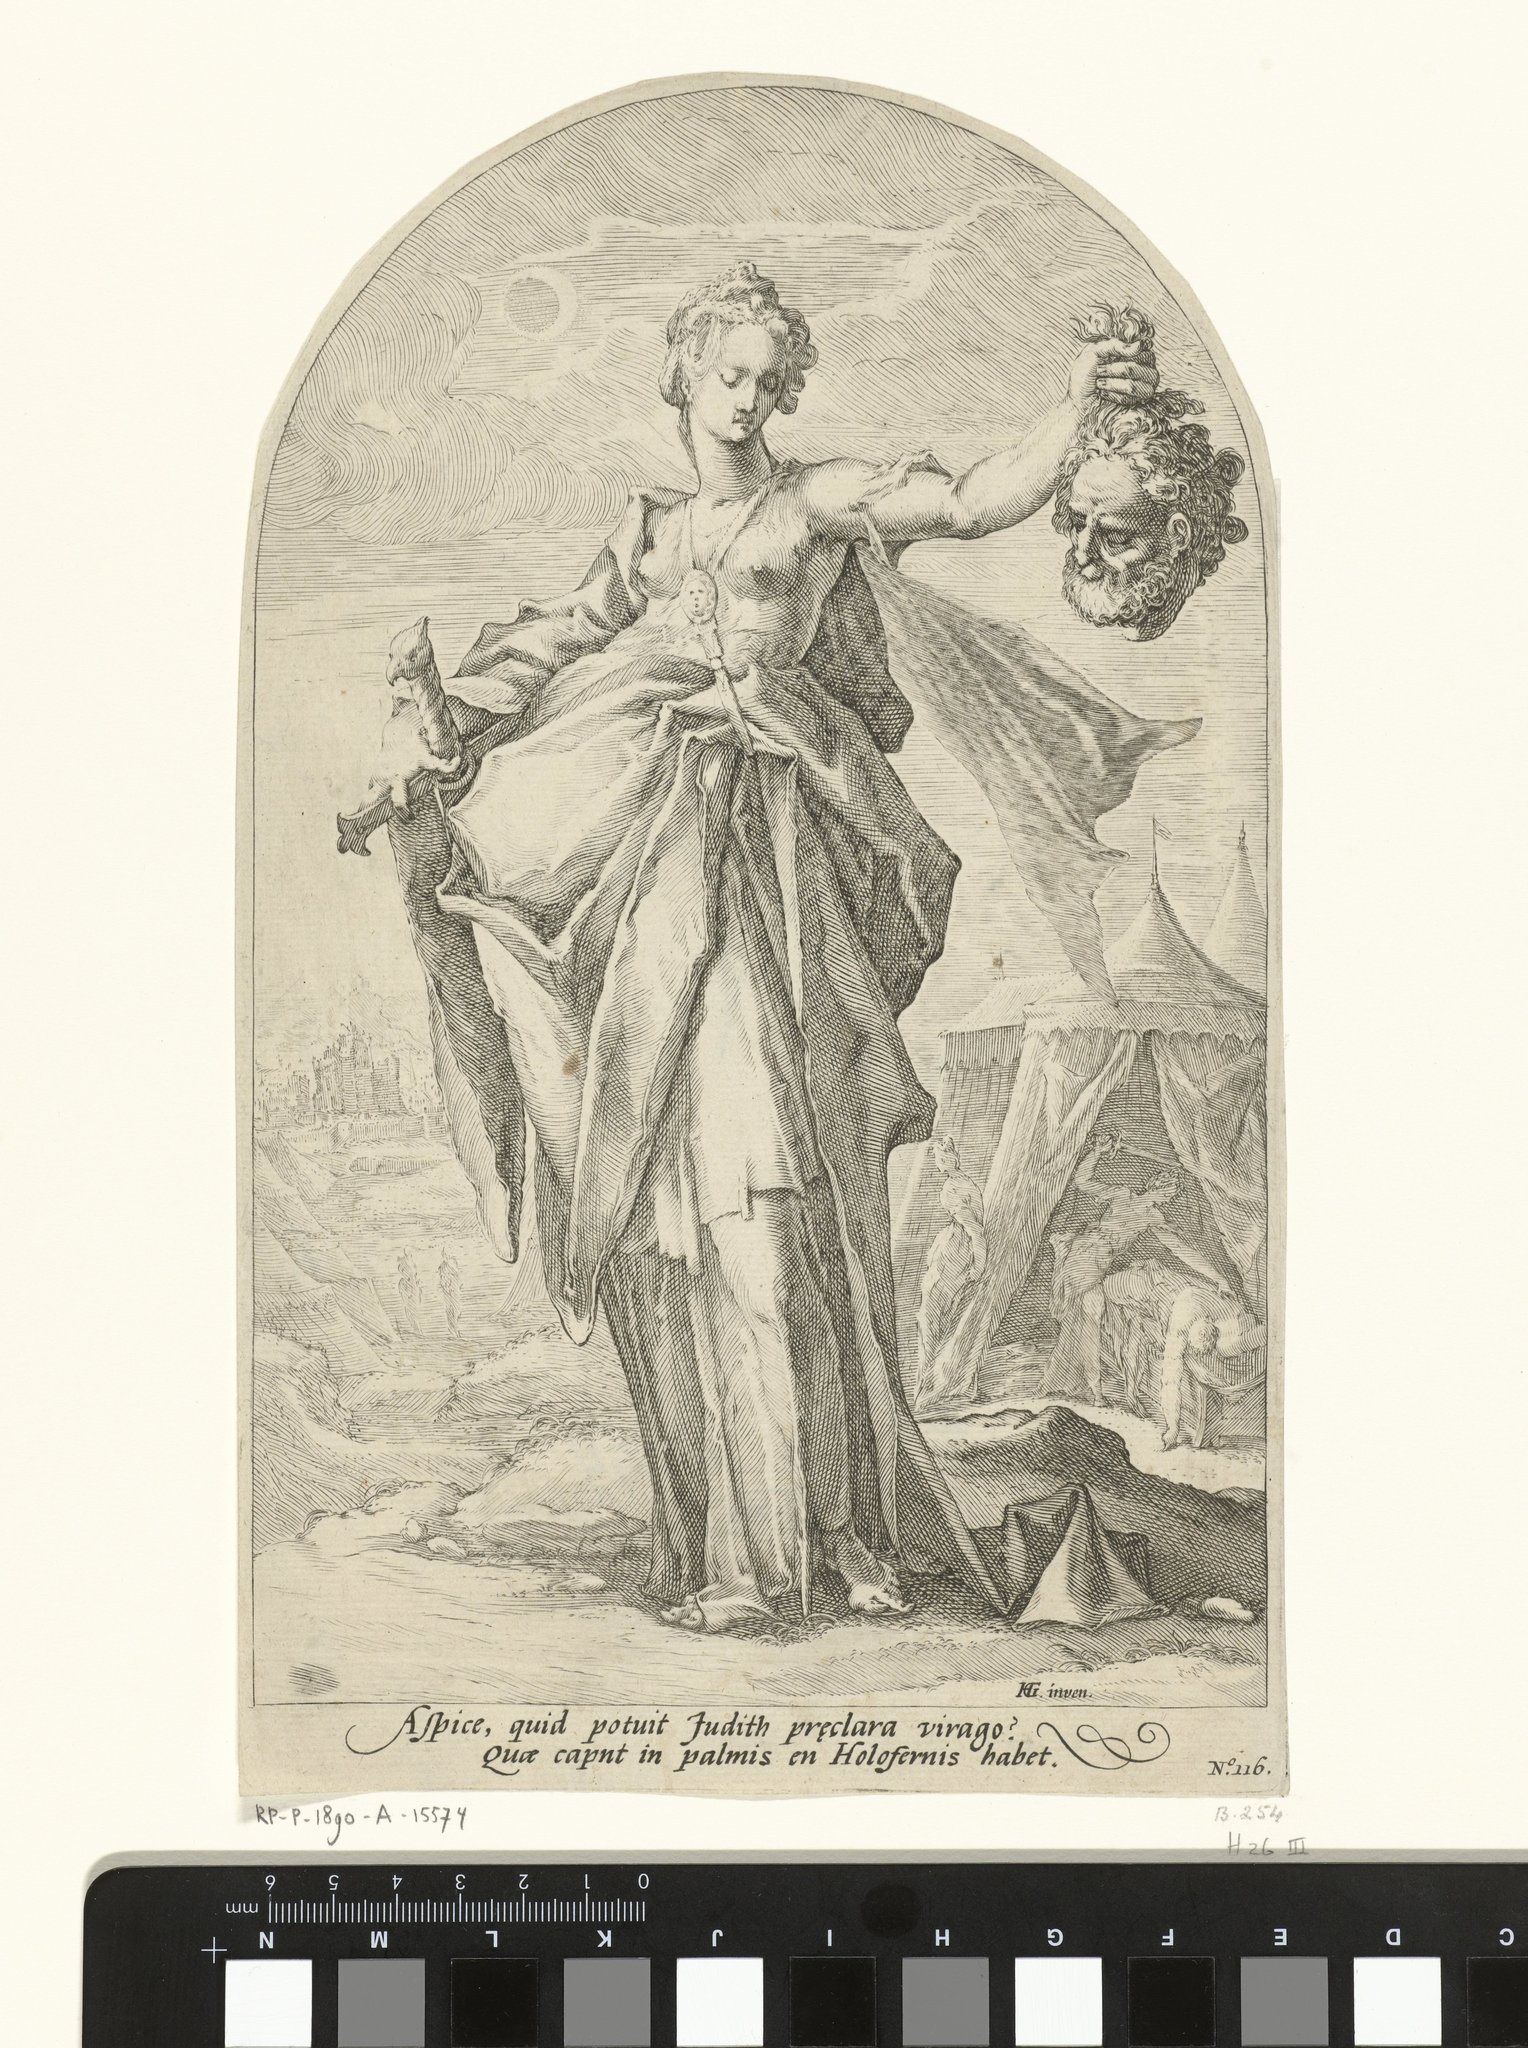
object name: print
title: Judit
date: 1585-1589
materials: paper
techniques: engraving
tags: judith with holofernes' head and the sword, holofernes beheaded by judith with his own sword; the maidservant may be keeping watch, female persons from the old testament (with name) (not in biblical context), judith (one of the nine worthiest women)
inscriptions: collector's mark: Lugt 2228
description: Judit met het hoofd van Holofernes in de ene, het zwaard in de andere hand. Op de achtergrond de scène waarin zij de legeraanvoerder in zijn tent het hoofd afhakt, terwijl haar dienstmaagd op wacht staat. Rechtsonder gemerkt: No. 116.